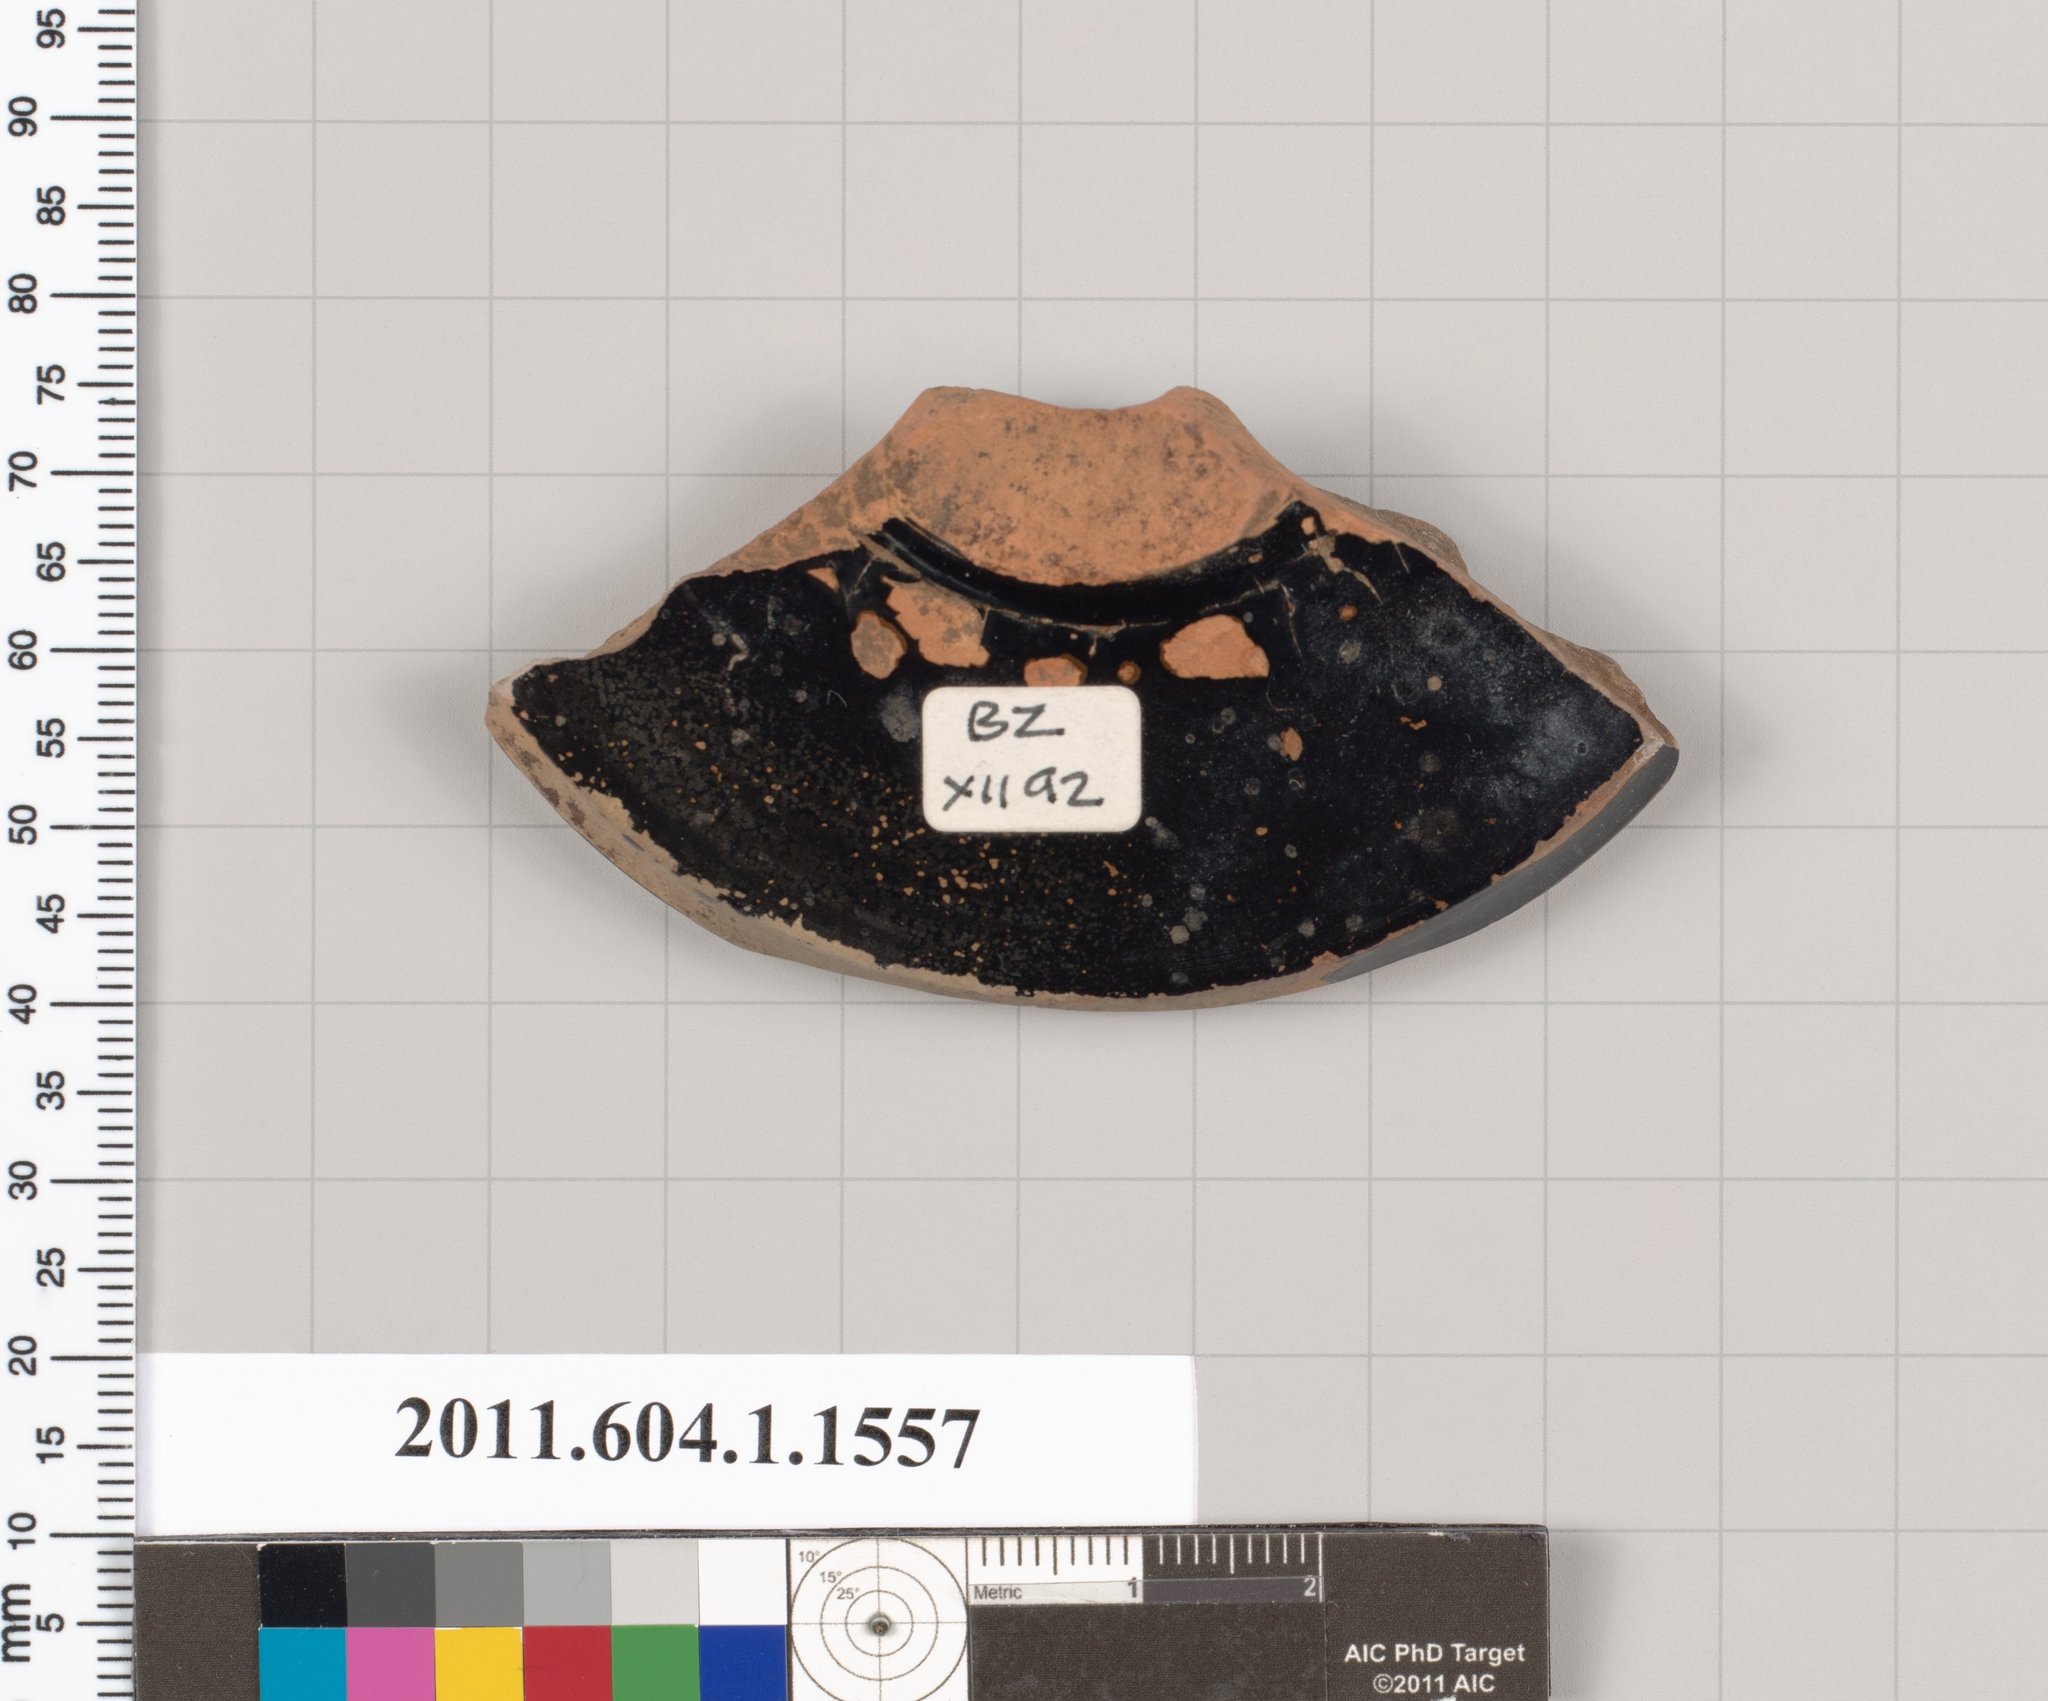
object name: kylix fragment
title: Terracotta fragment of a kylix (drinking cup)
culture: greek, attic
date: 500-401 BCE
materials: terracotta